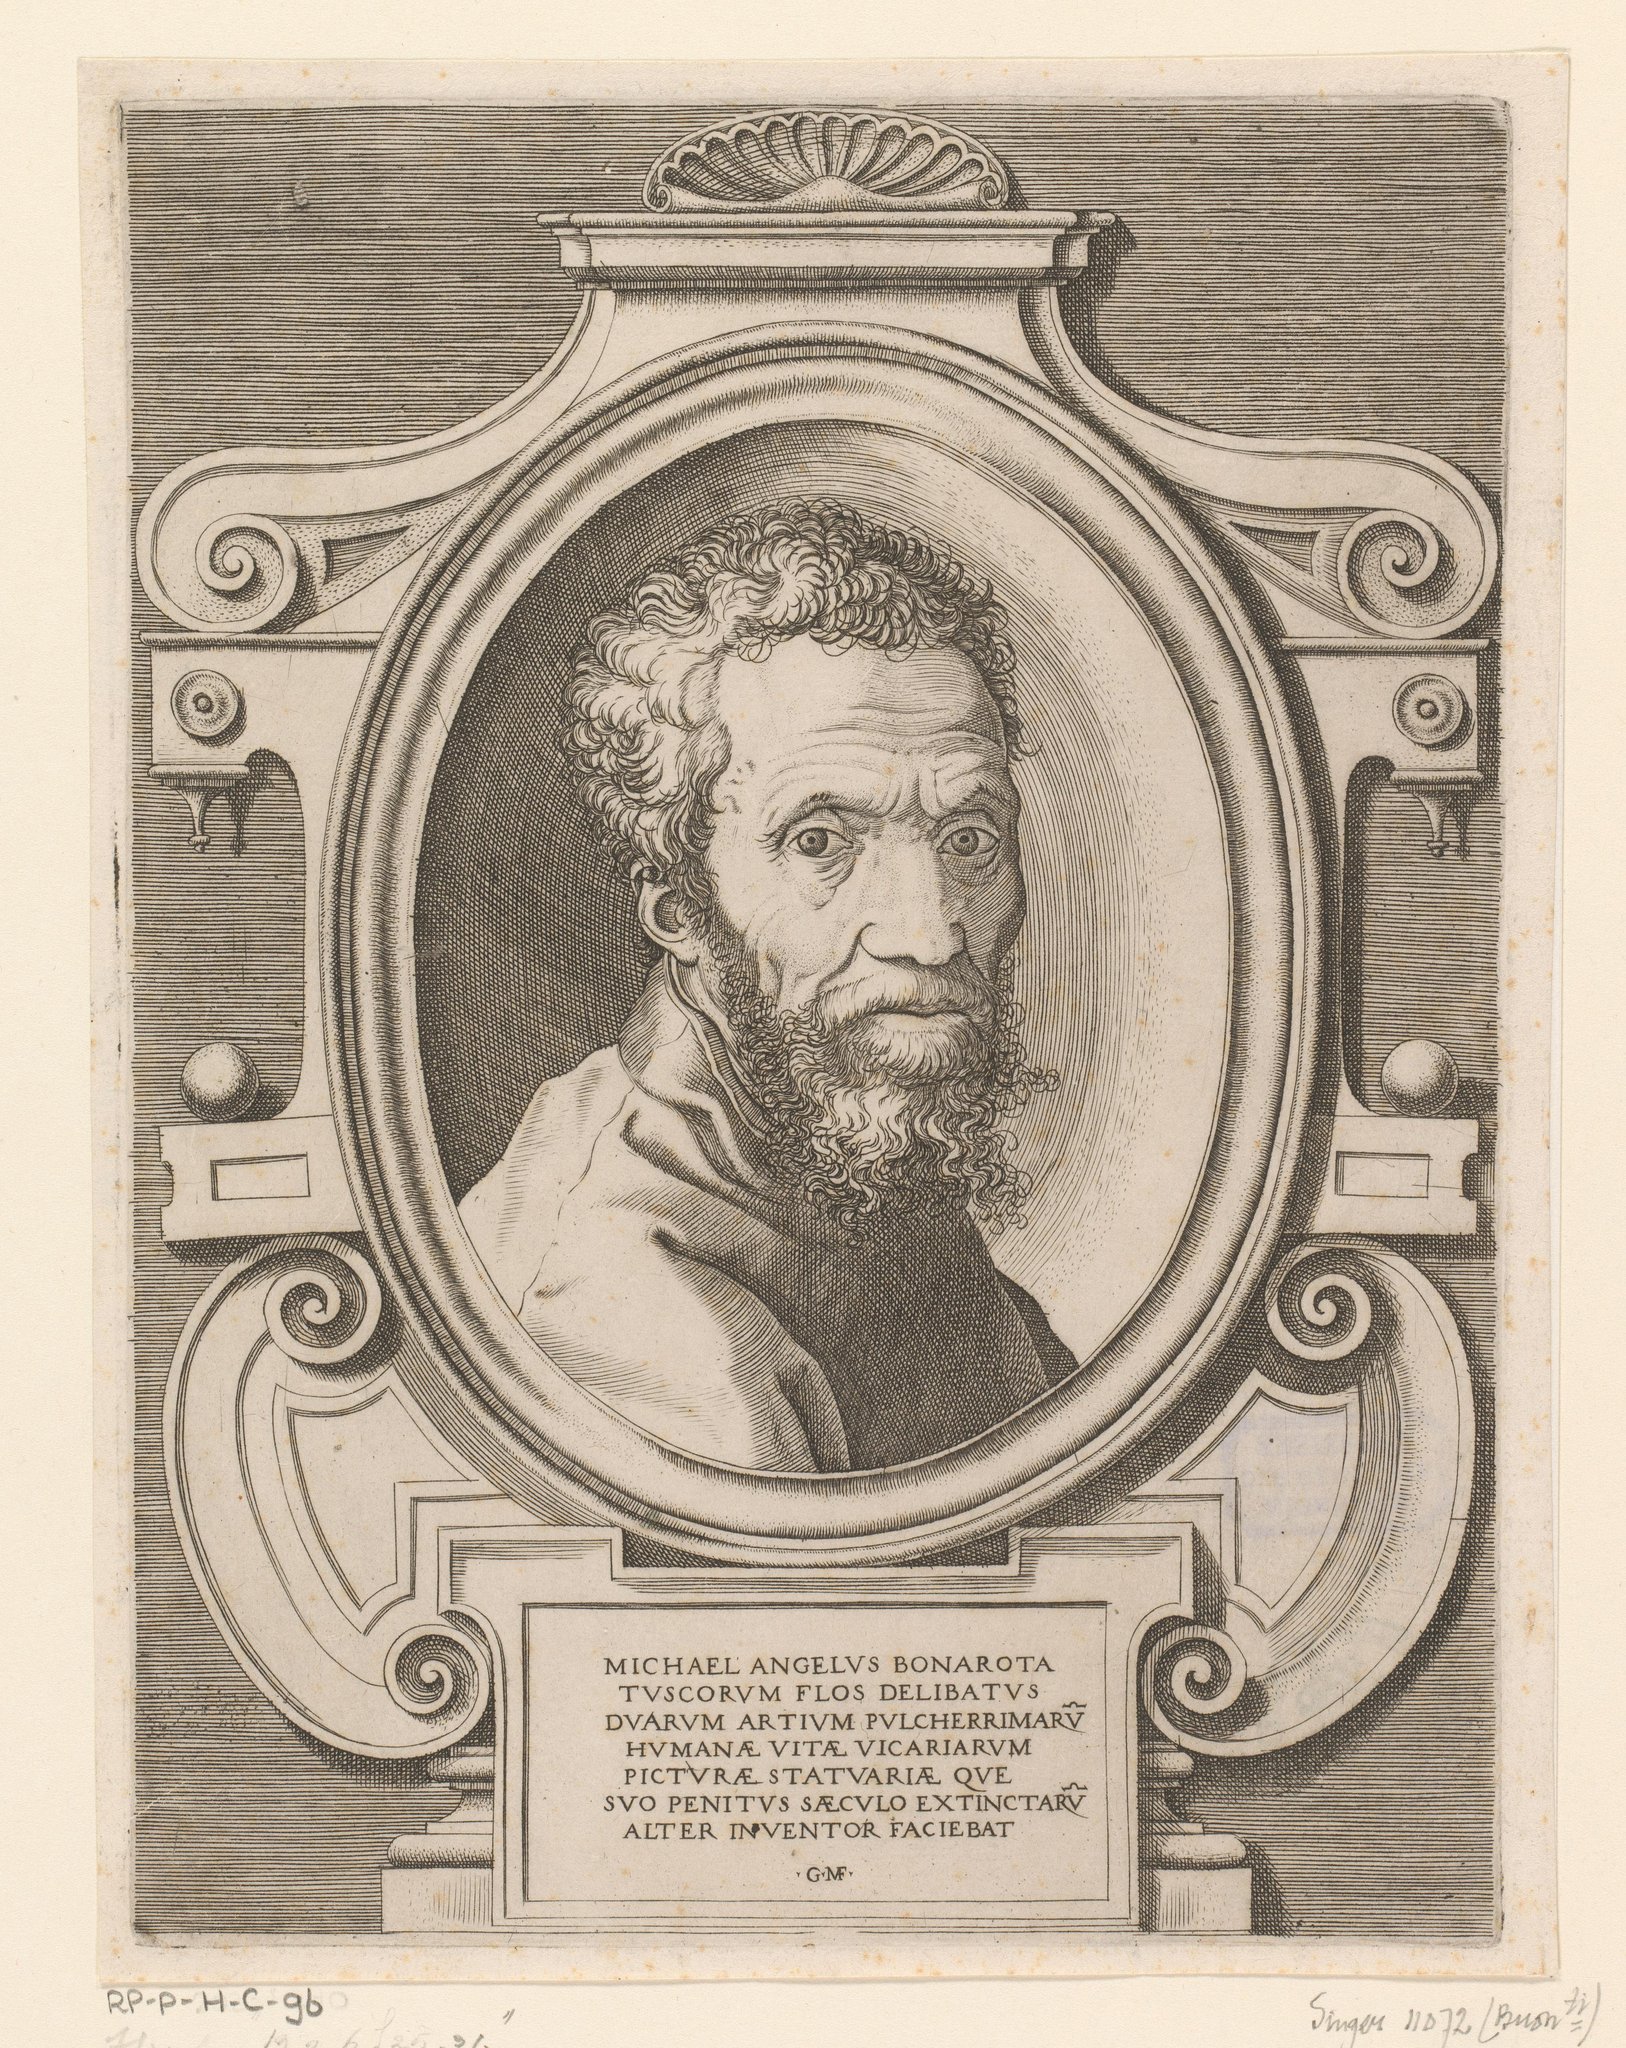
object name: print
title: Portret van Michelangelo Buonarroti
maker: giorgio ghisi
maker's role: print maker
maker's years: 1520-1582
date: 1530-1582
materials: paper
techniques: engraving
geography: italy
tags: rome, painter, draughtsman, sculptor, michelangelo, historical persons, portrait, self-portrait of artist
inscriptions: collector's mark: Lugt 11, collector's mark: Lugt 10